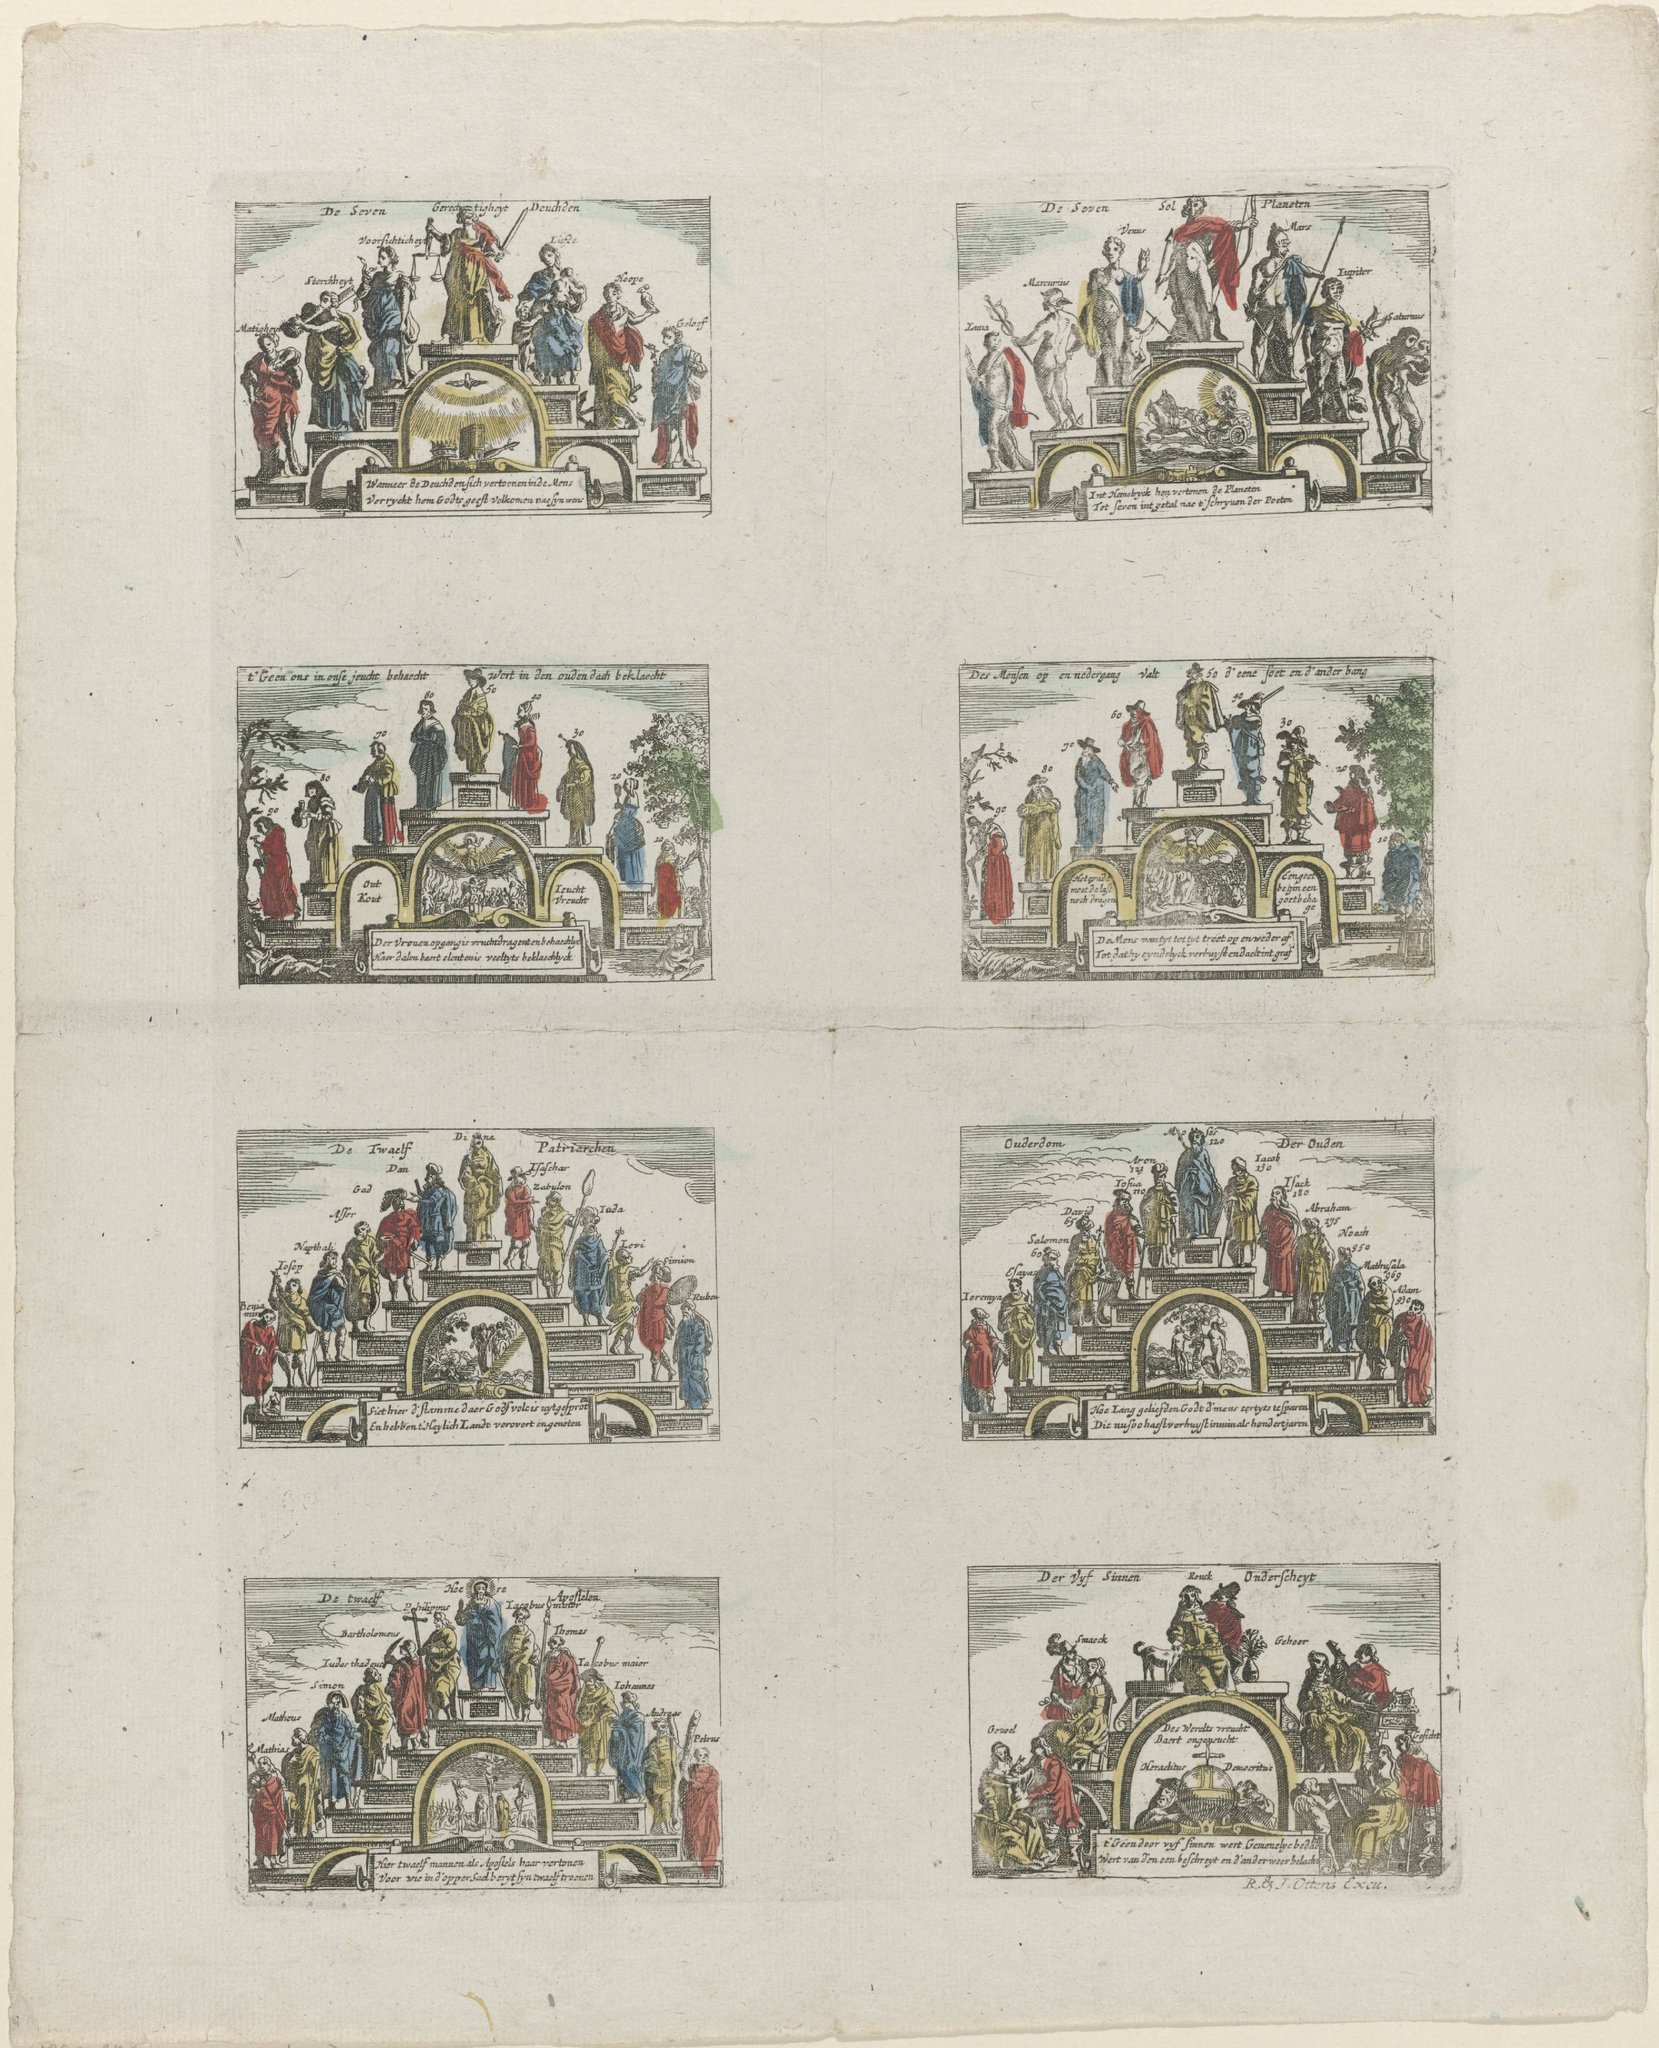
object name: popular print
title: Trappen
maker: Anonymous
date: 1726-1750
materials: paper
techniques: colour, engraving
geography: netherlands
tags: the twenty-four elders, ladder of virtues, the twelve apostles ~ the twelve patriarchs, the (five) senses, the ages of man represented by a staircase, planets (except the earth)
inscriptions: collector's mark: Lugt 2760, address: ‘R. & J. Ottens Excu.’, collector's mark: Lugt 2228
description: Blad met 8 voorstellingen van verschillende trappen, zoals een trap met de zeven deugden, een trap met de planeten, trappen des ouderdoms, een trap met patriarchen, een trap met de apostelen, een trap met de ouderlingen en een trap met de vijf zintuigen. Onder in elke voorstelling een cartouche met tweeregelig vers.